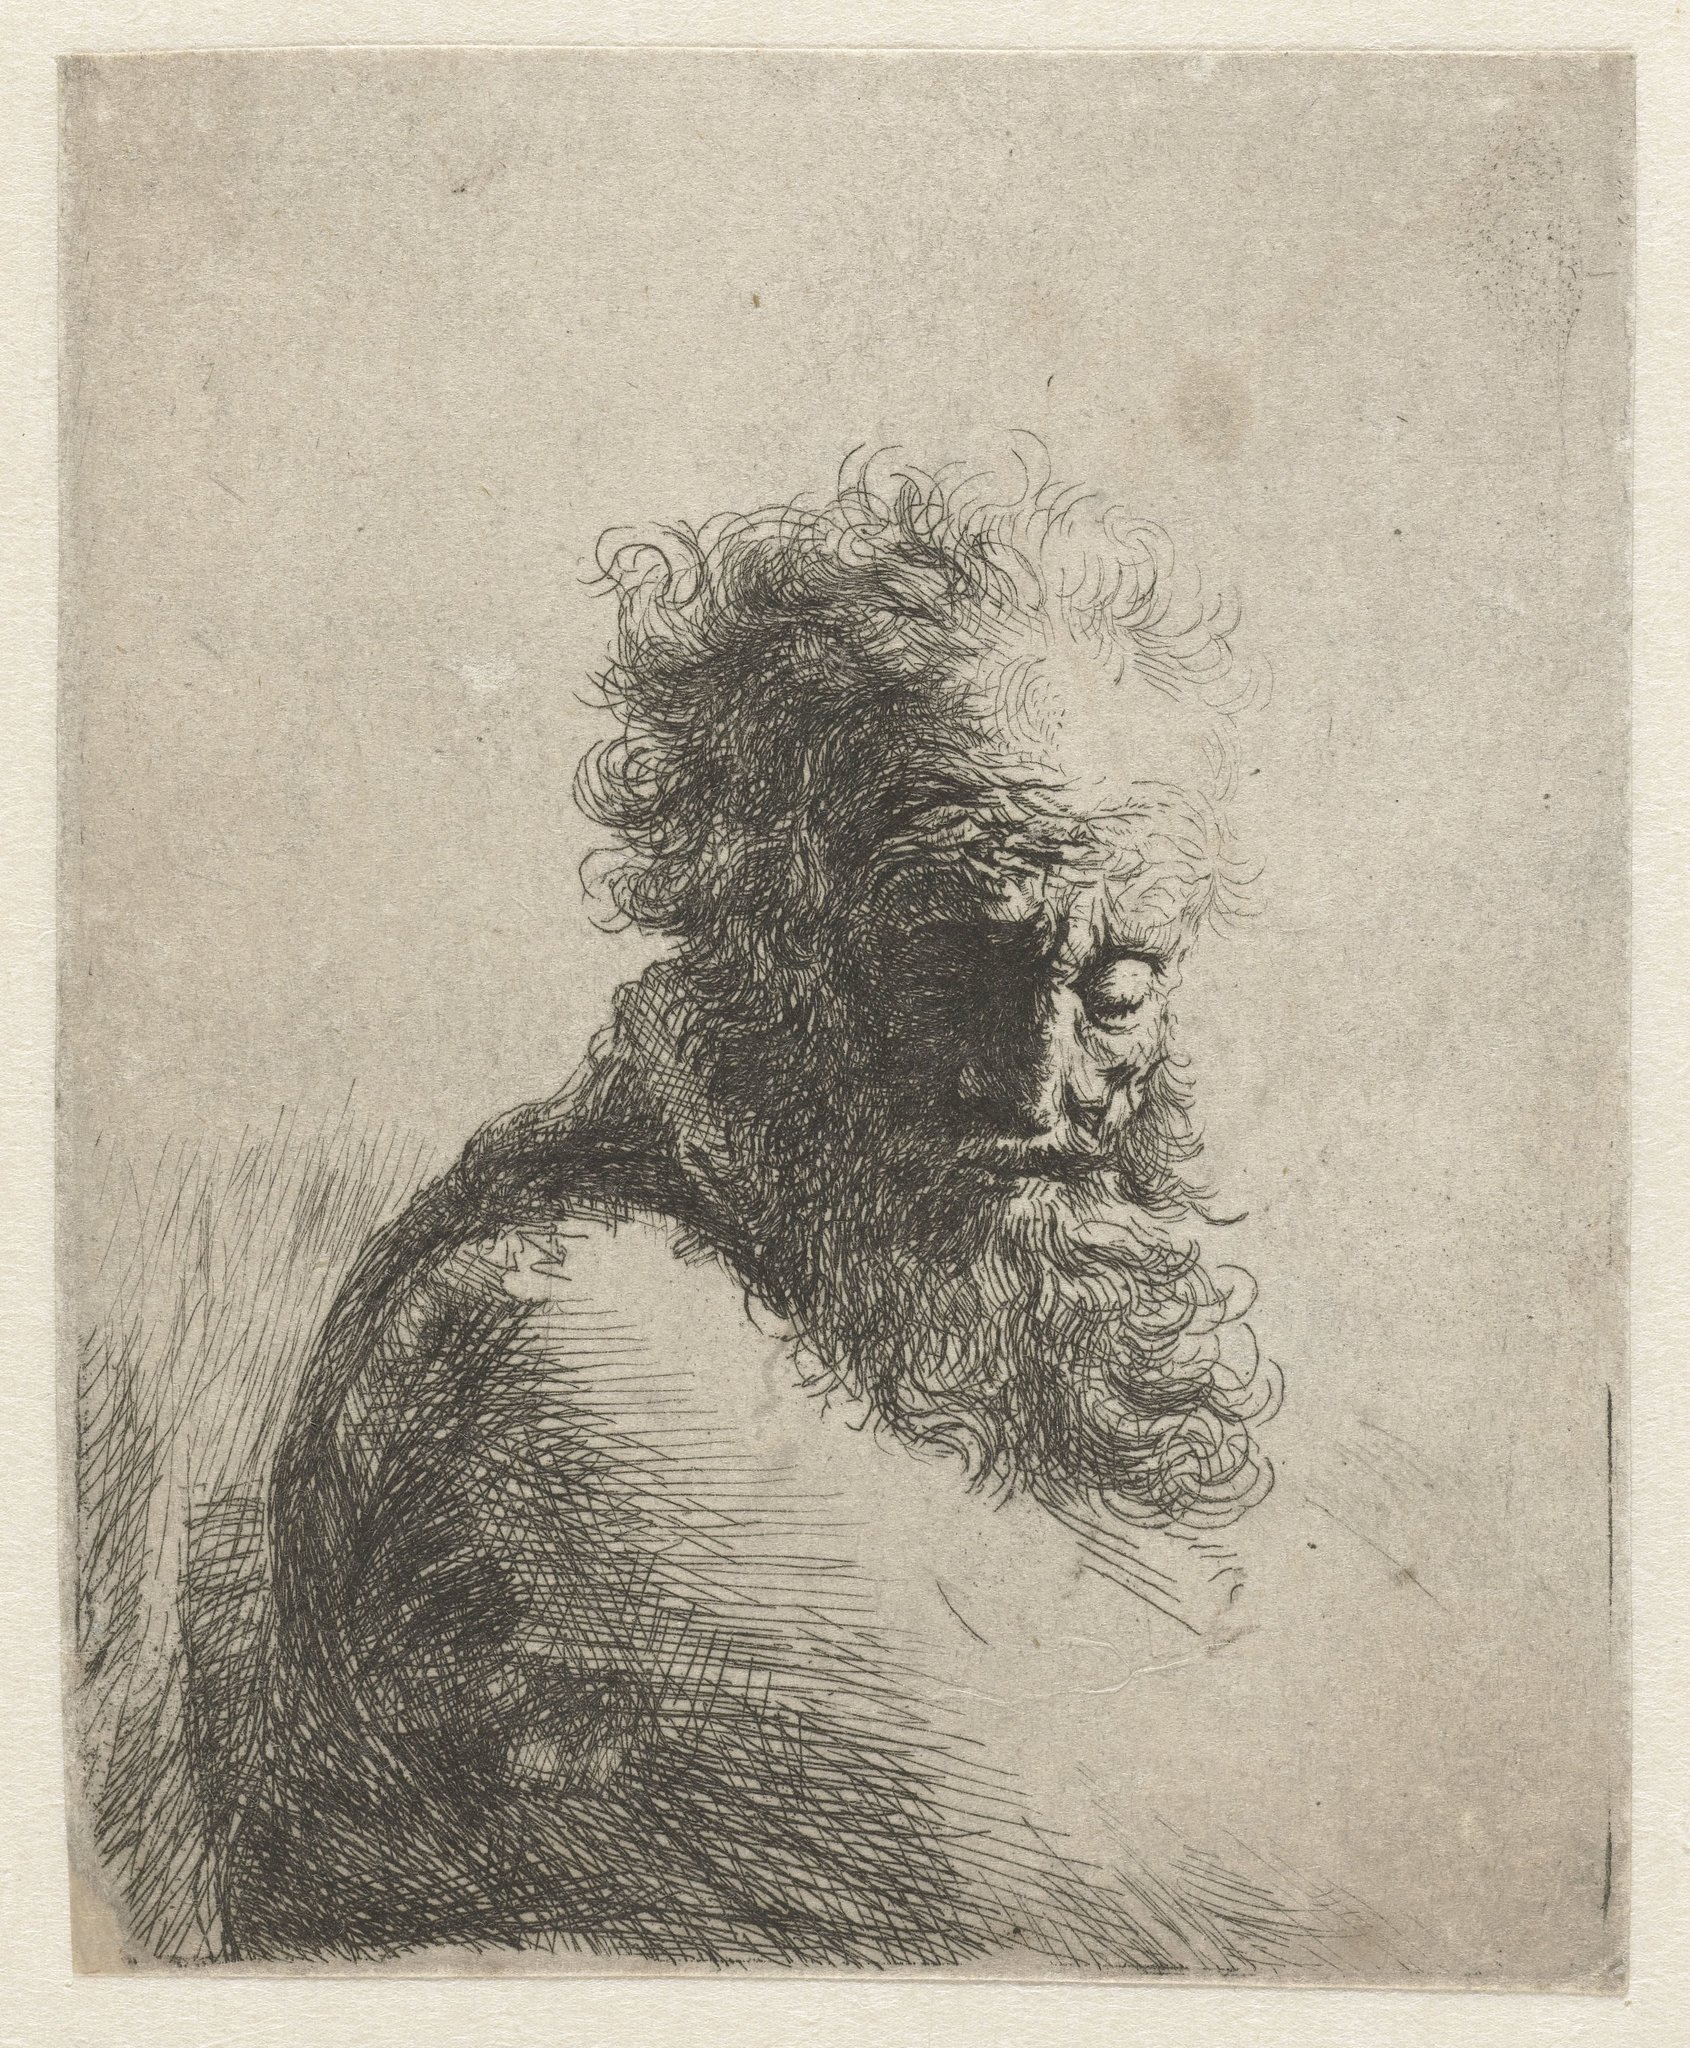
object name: titelblad, titelpagina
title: Actrice, mogelijk in de rol van Medusa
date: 1770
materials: paper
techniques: aquatint, etching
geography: lausanne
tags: actor (on the stage), cupids: 'amores', 'amoretti', 'putti'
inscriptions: collector's mark: Lugt 2228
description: Titelpagina voor: Coqueley de Chaussepierre, Charles-Georges. Le Roué vertueux, poëme en prose, en quatre chants, propre à faire, en cas de besoin, un drame à jouer deux fois par semaine, Lausanne: s.n., 1770.